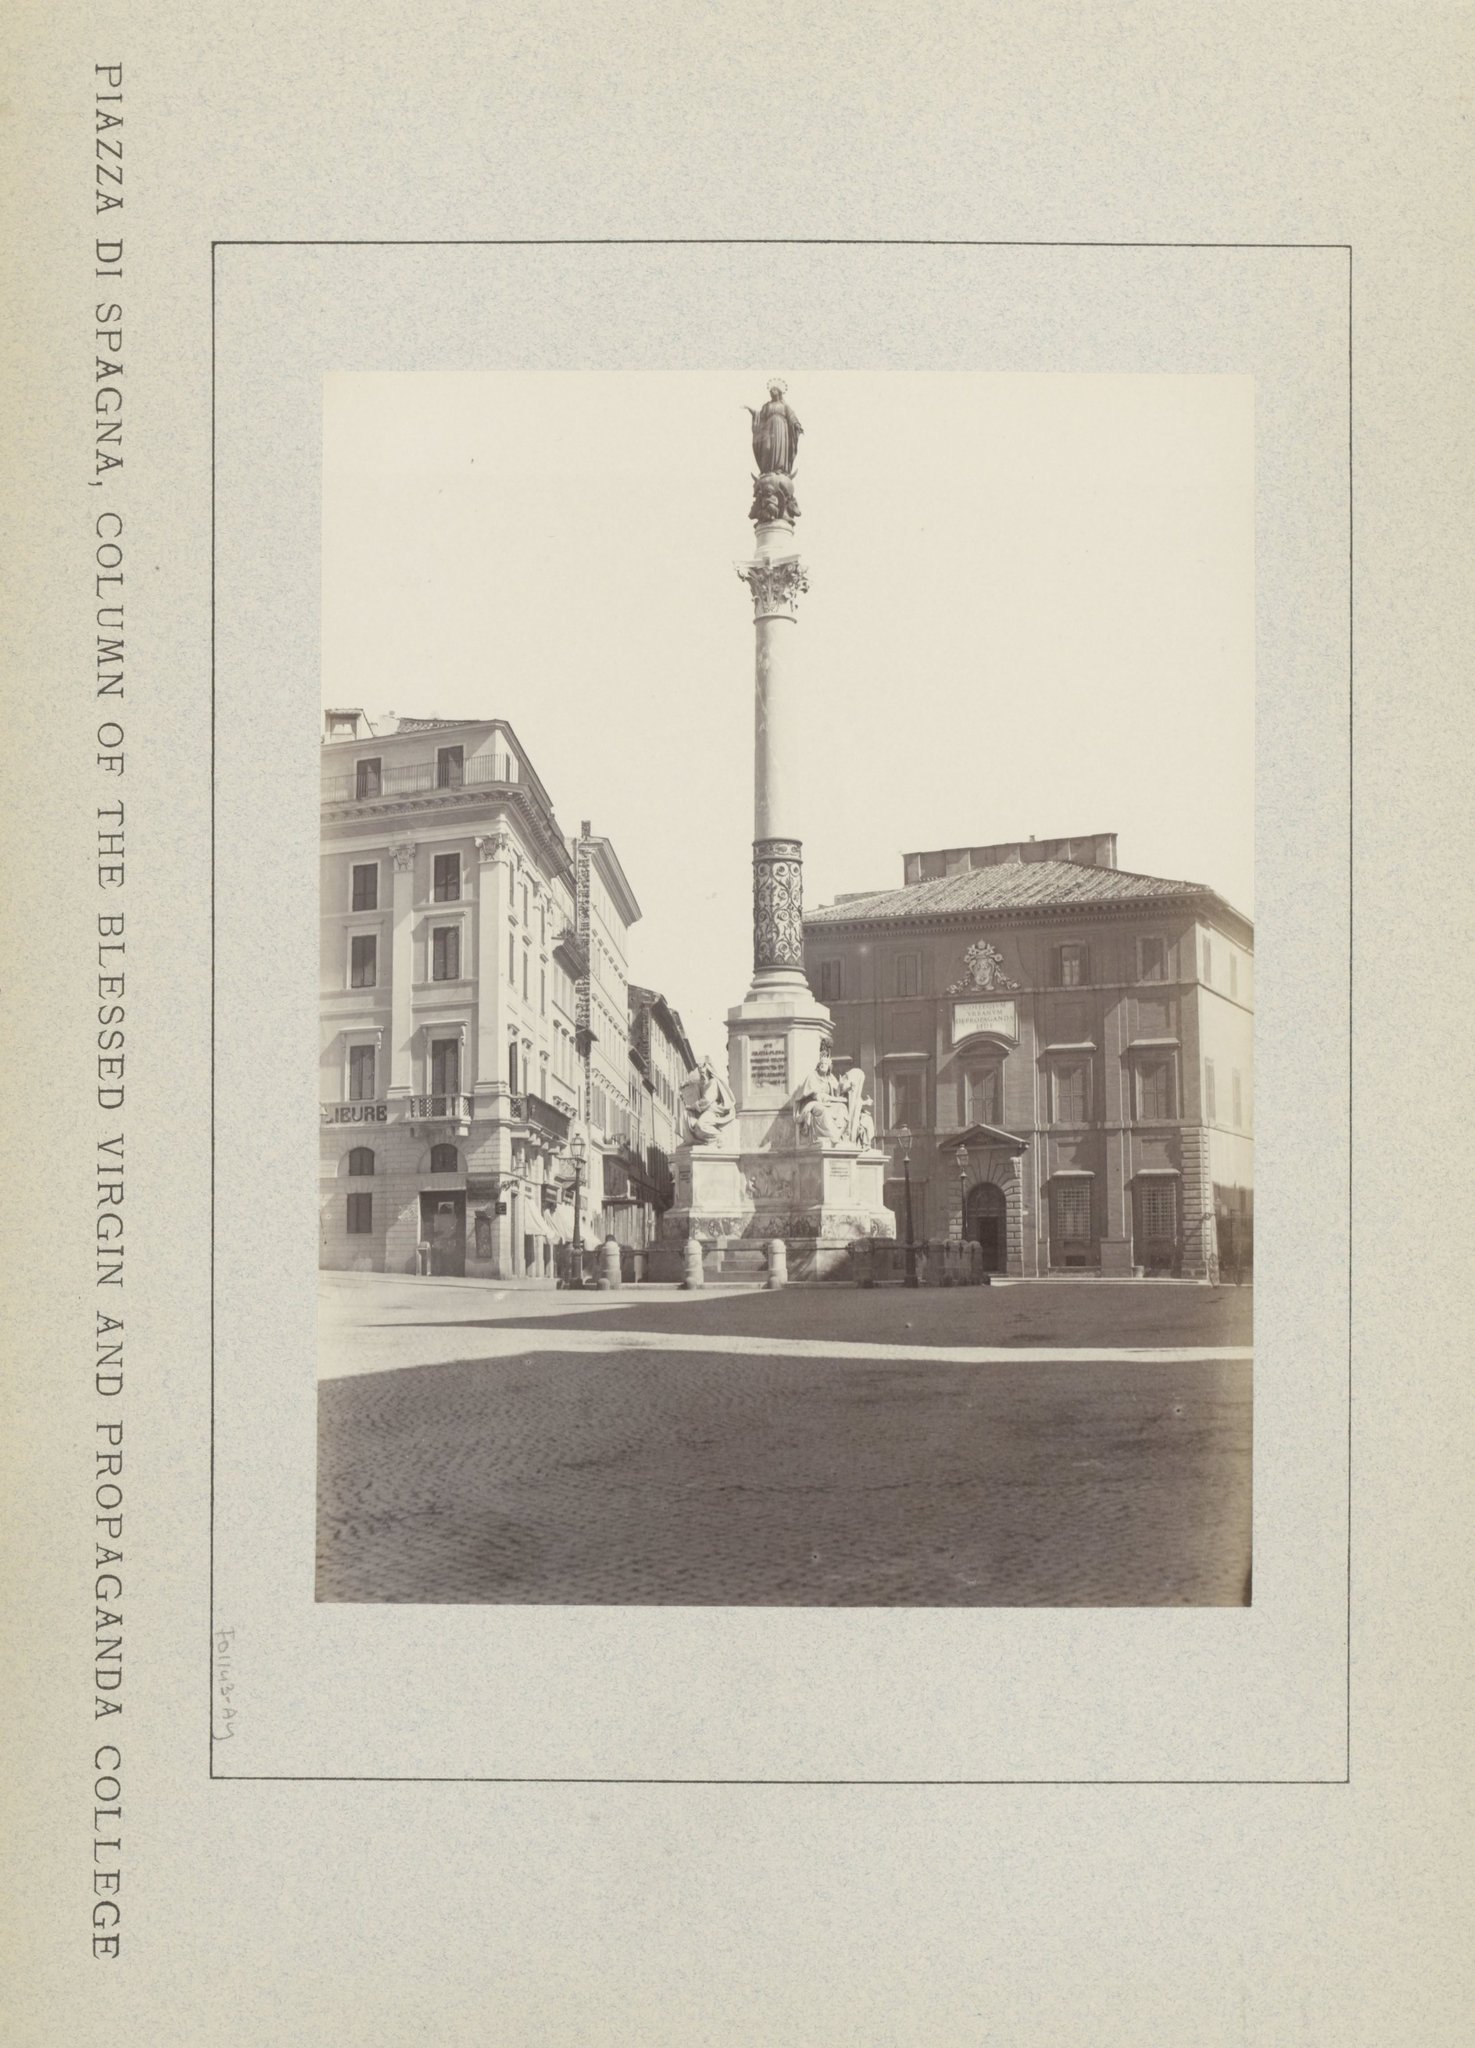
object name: photograph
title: Piazza di Spagna, column of the blessed Virgin and Propaganda college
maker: Anonymous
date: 1860-1900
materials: photographic support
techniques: albumen print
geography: rome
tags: column, pillar ~ architecture, façade (of house or building), square, place, circus, etc. (+ city(-scape) with figures, staffage)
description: Onderdeel van Fotoalbum met opnames van bezienswaardigheden en kunstwerken in Rome.